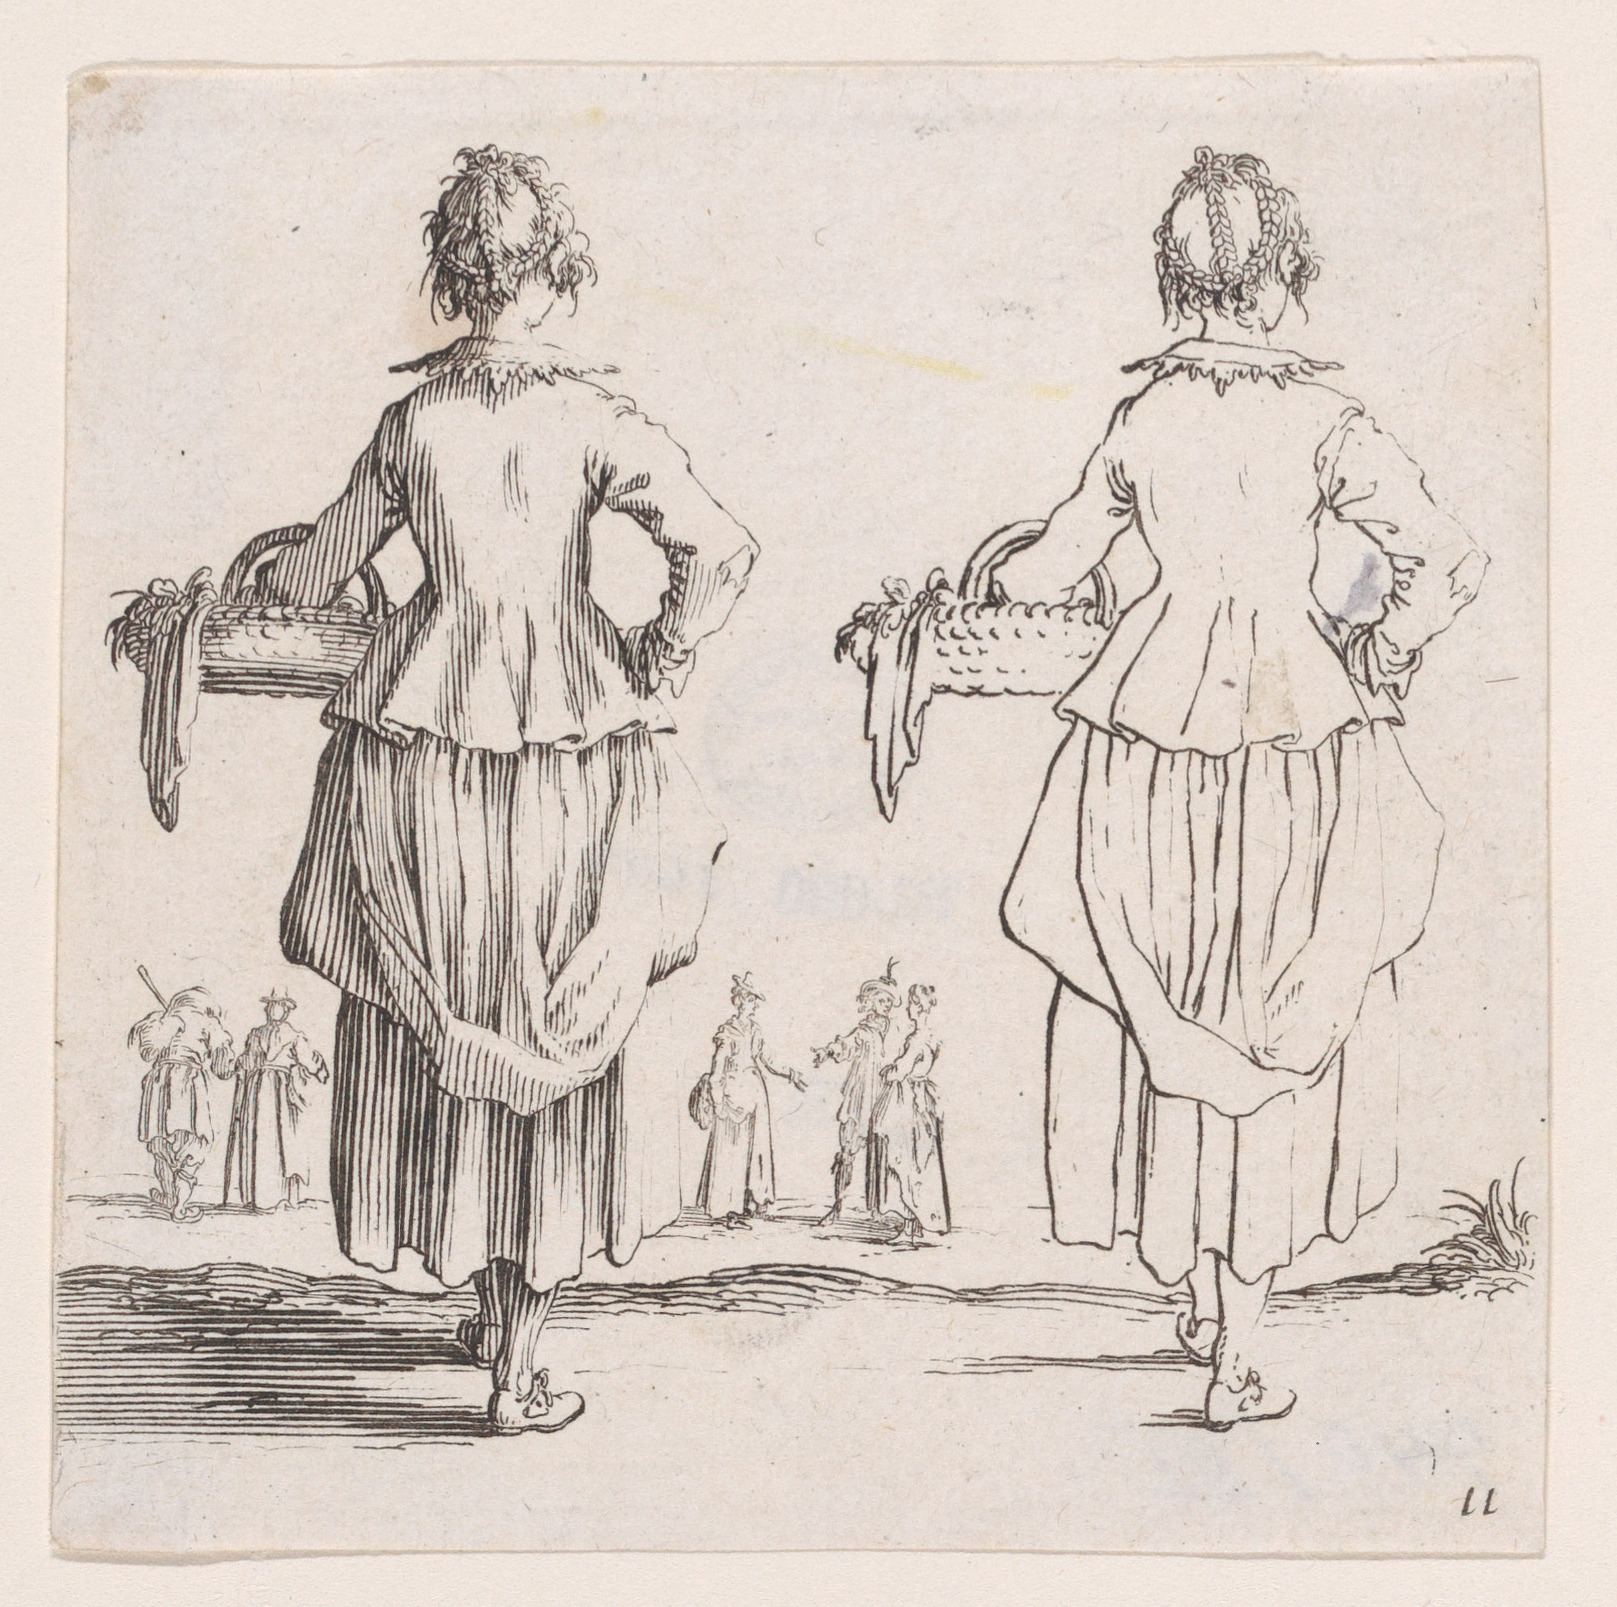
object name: print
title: La Paysanne Vue de Dos, Tenant un Panier a son Bras Gauche (The Peasant Woman Viewed from Behind, Holding a Basket in his Left Arm), plate 11 from "Varie Figure" (Various Figures)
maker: jacques callot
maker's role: artist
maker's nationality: french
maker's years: 1592-1635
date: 1620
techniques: etching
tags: women,baskets